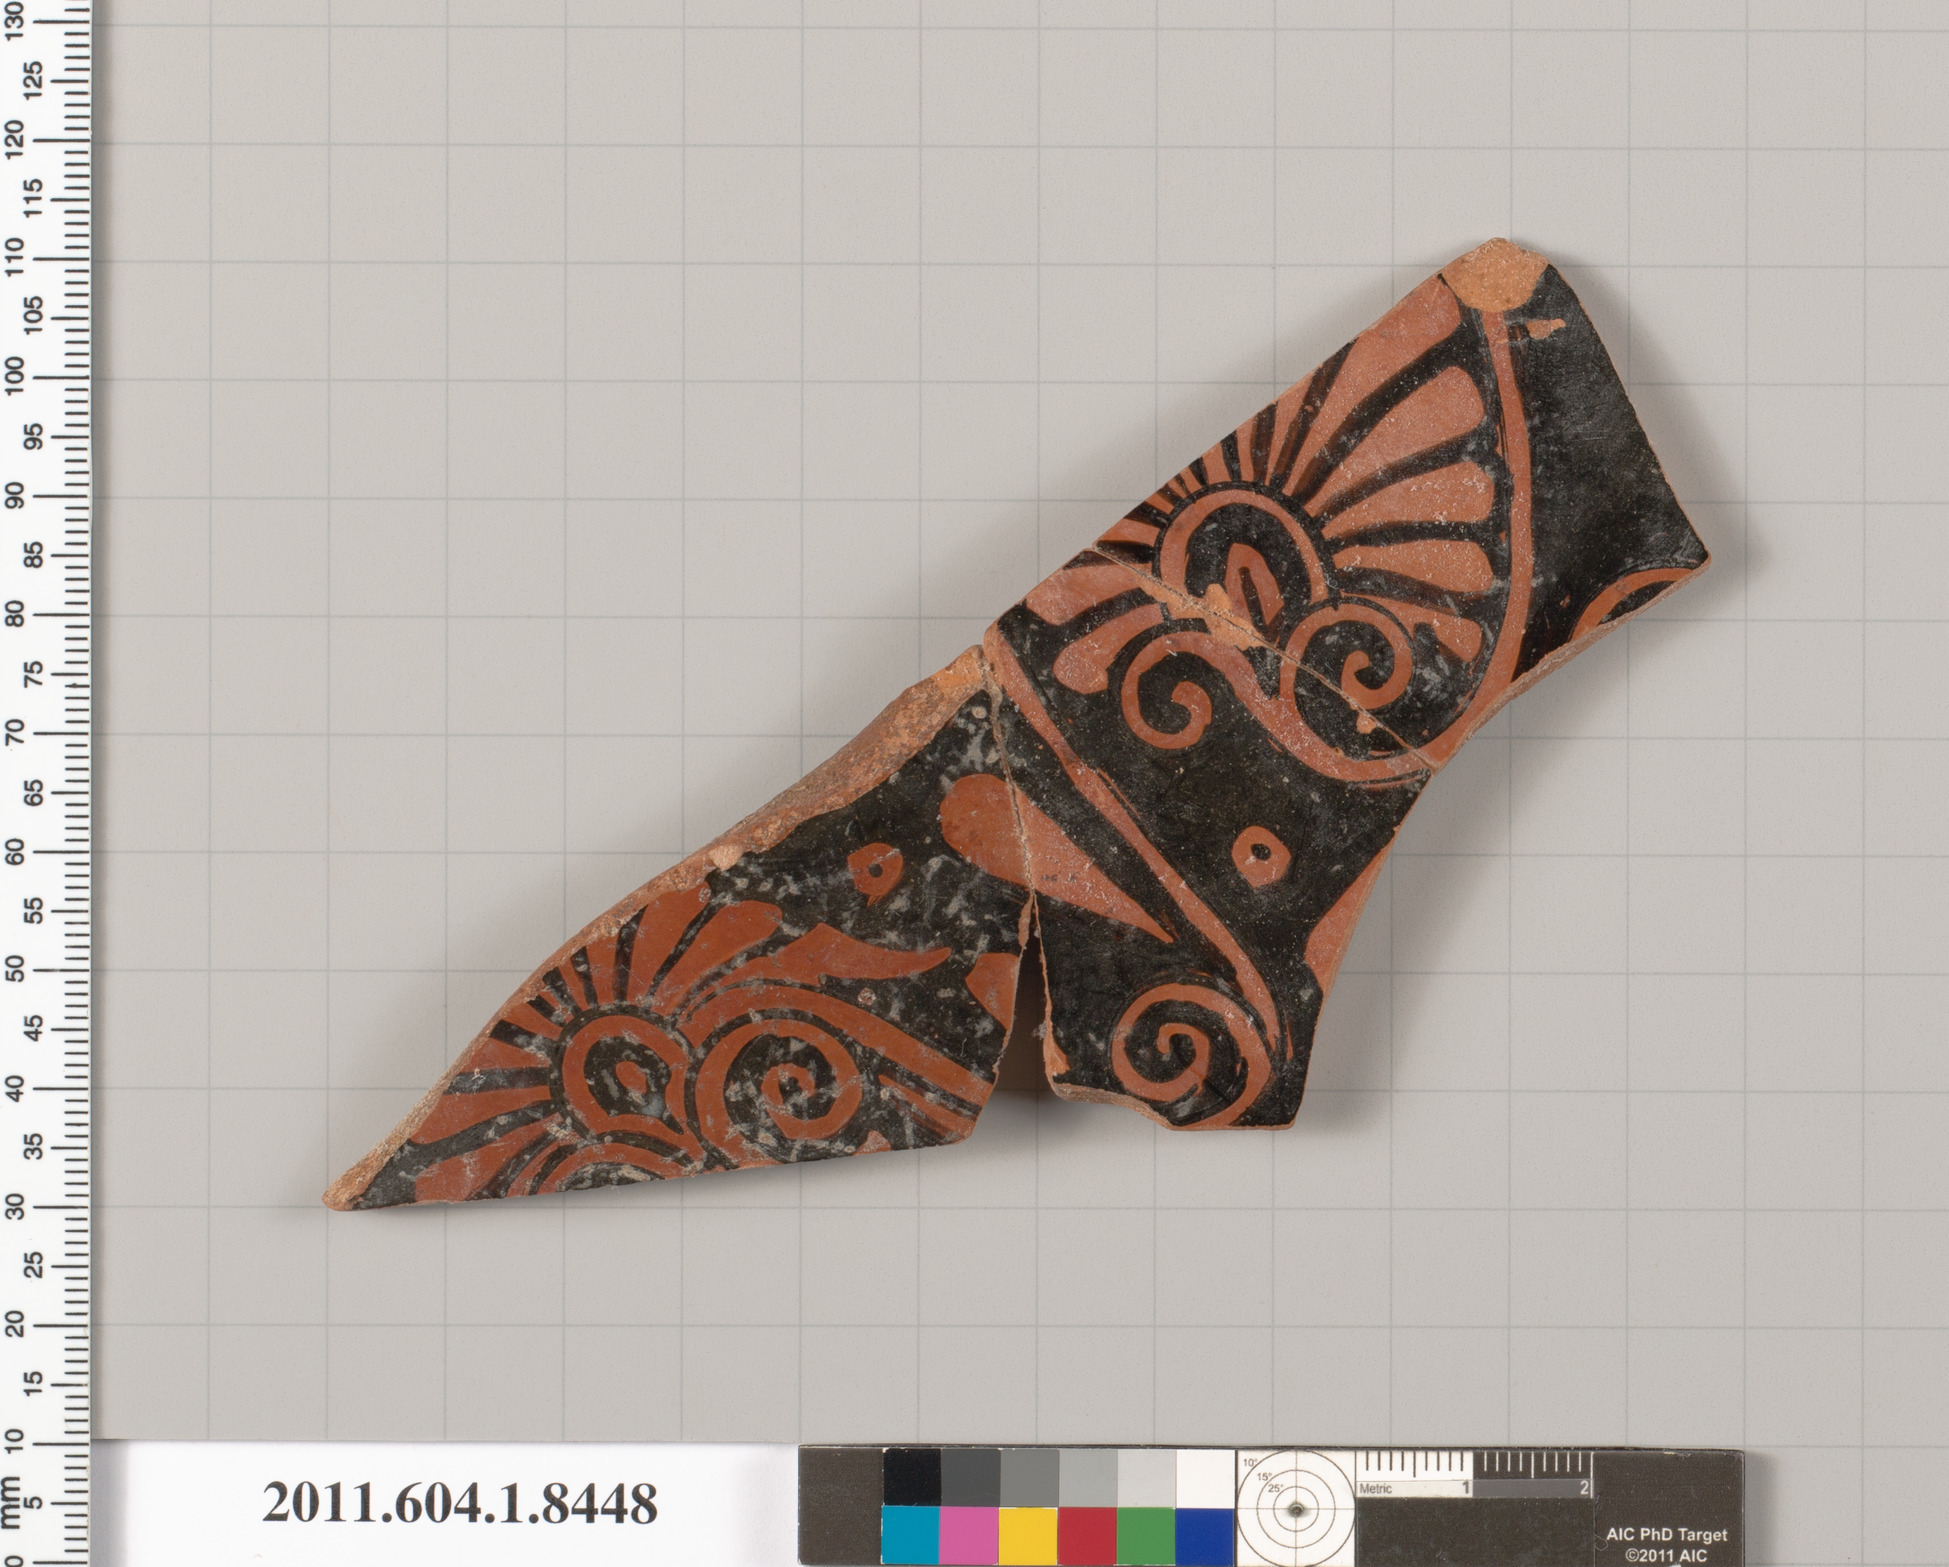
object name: kylix fragment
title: Terracotta fragment of a kylix (drinking cup)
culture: greek, attic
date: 400-376 BCE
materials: terracotta